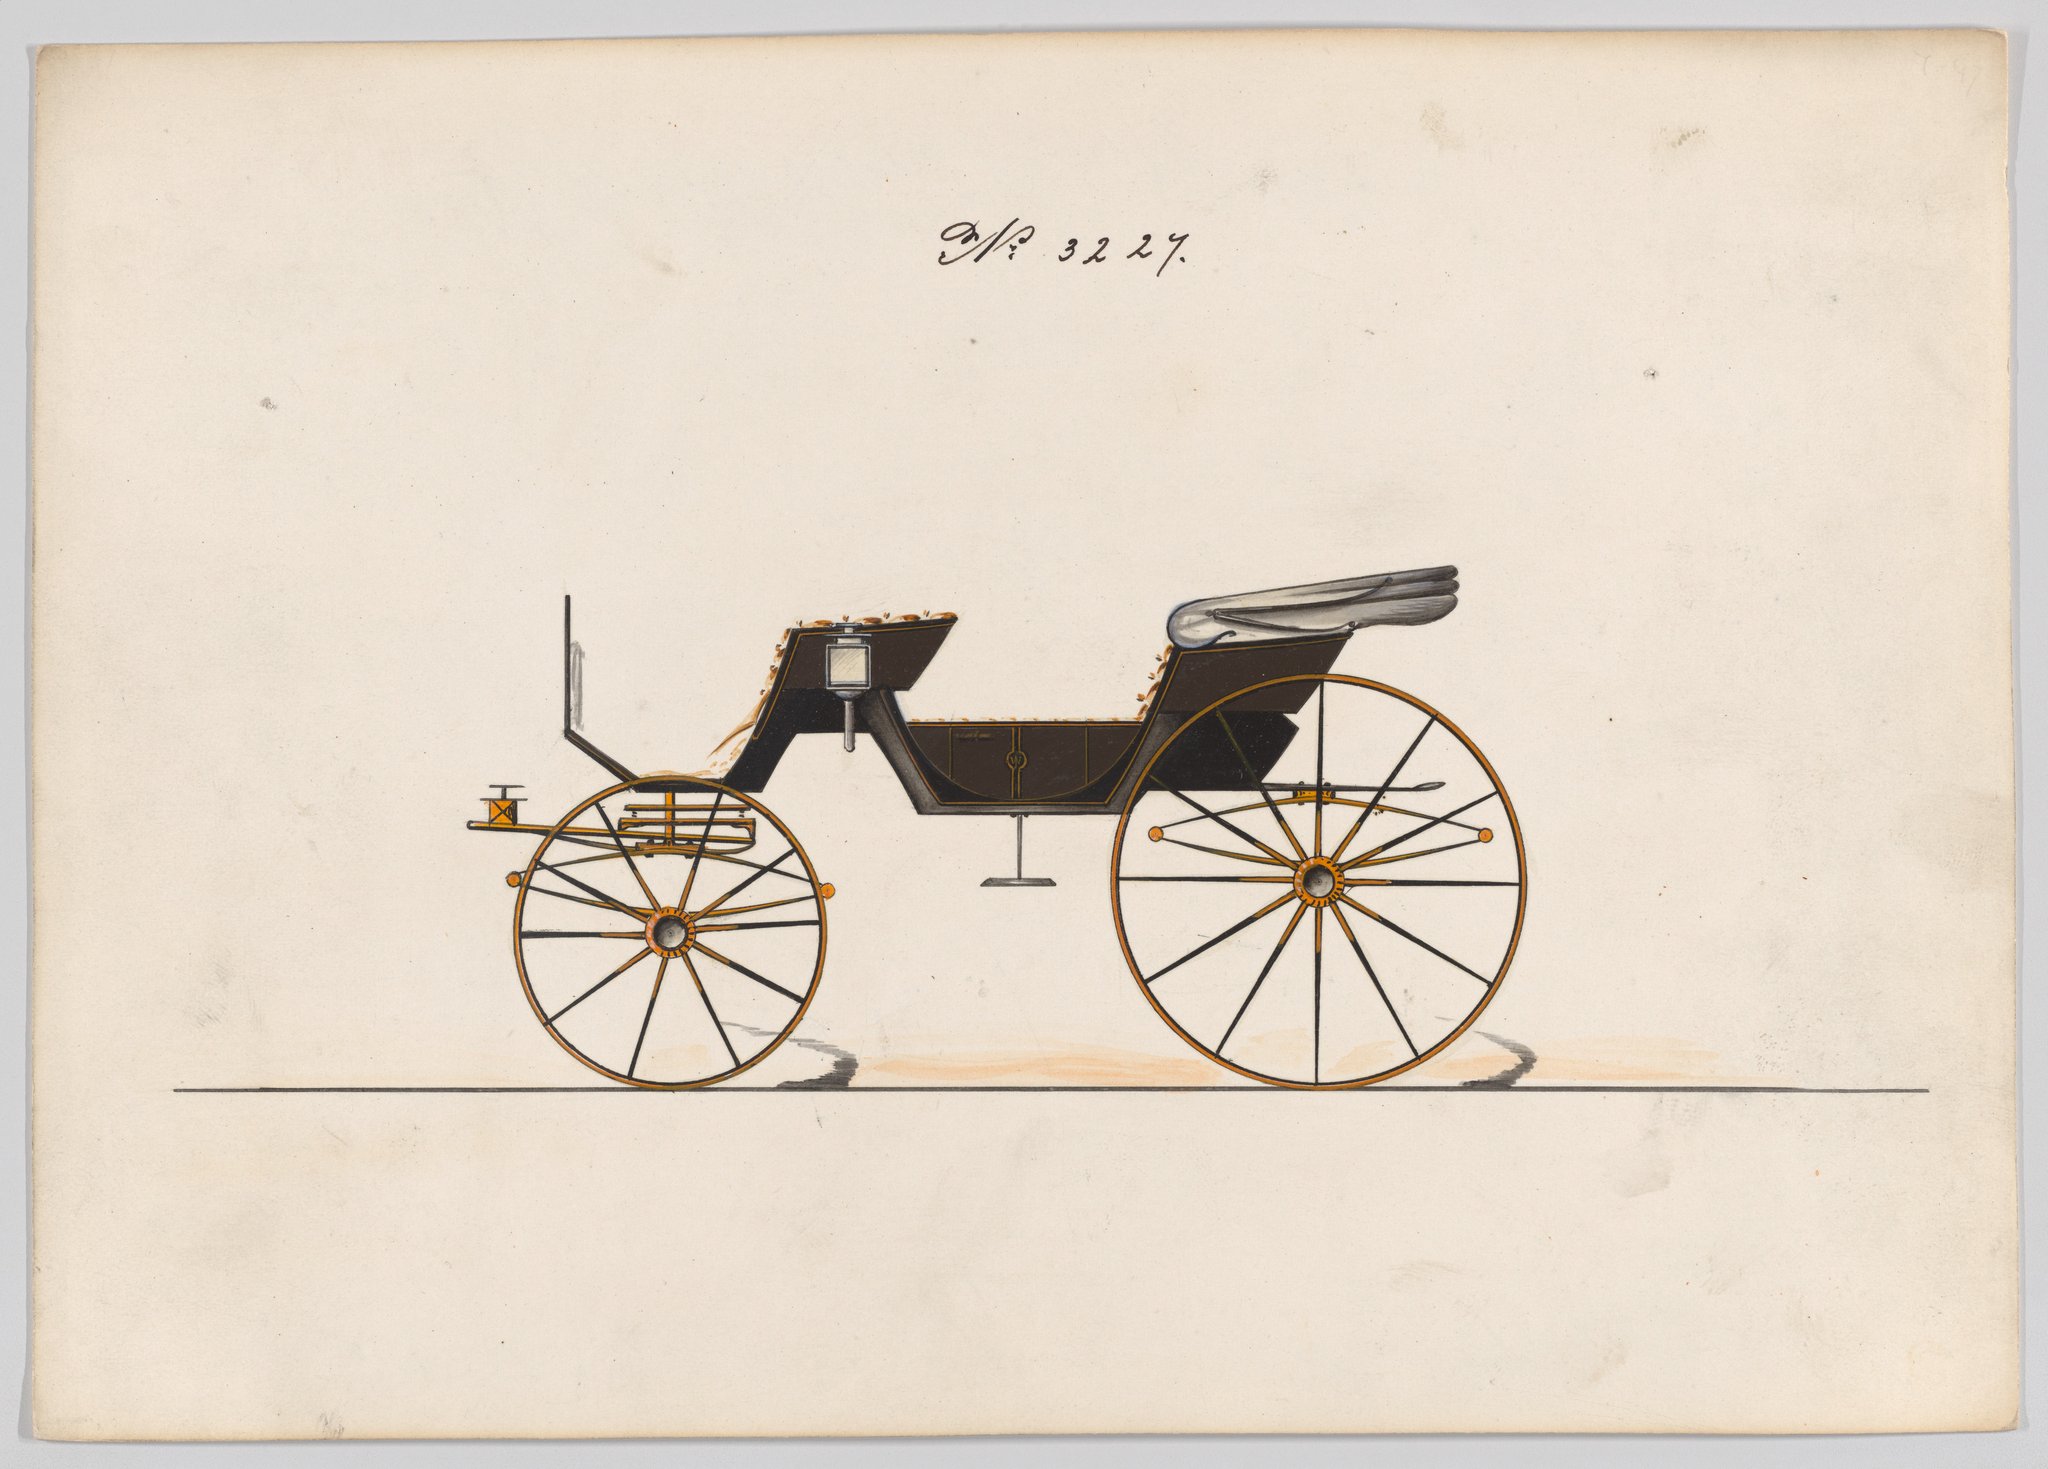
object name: drawing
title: Design for 2 seat Phaeton, no. 3227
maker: brewster & co.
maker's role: manufacturer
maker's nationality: american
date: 1876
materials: ink, watercolor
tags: carriages